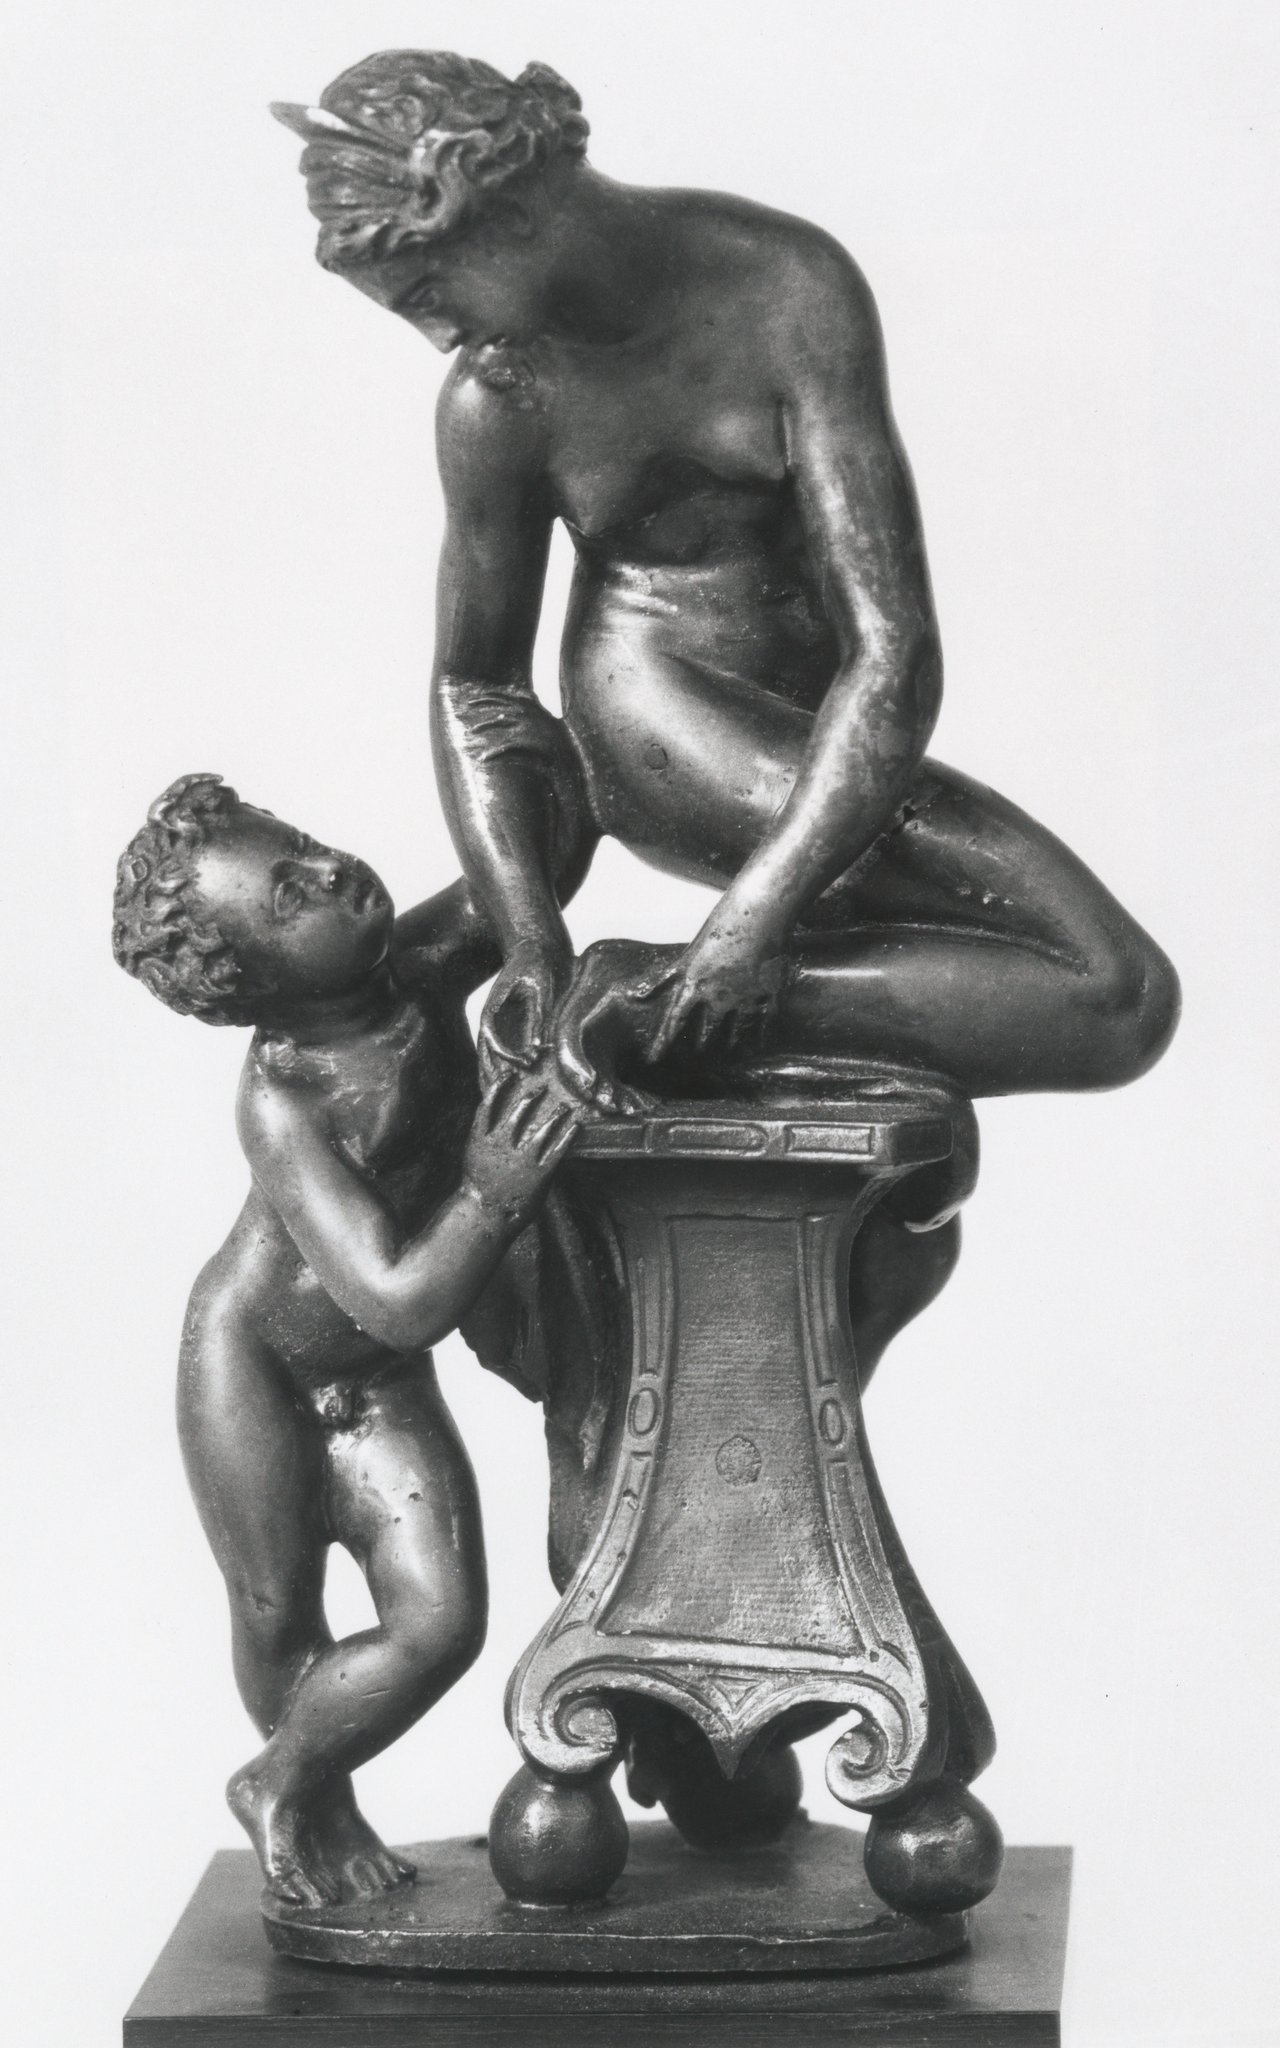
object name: statuette group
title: Venus and Cupid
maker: giambologna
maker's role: artist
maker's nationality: netherlandish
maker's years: 1529-1608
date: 1567-1633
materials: bronze, gold, lacquer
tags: cupid,venus